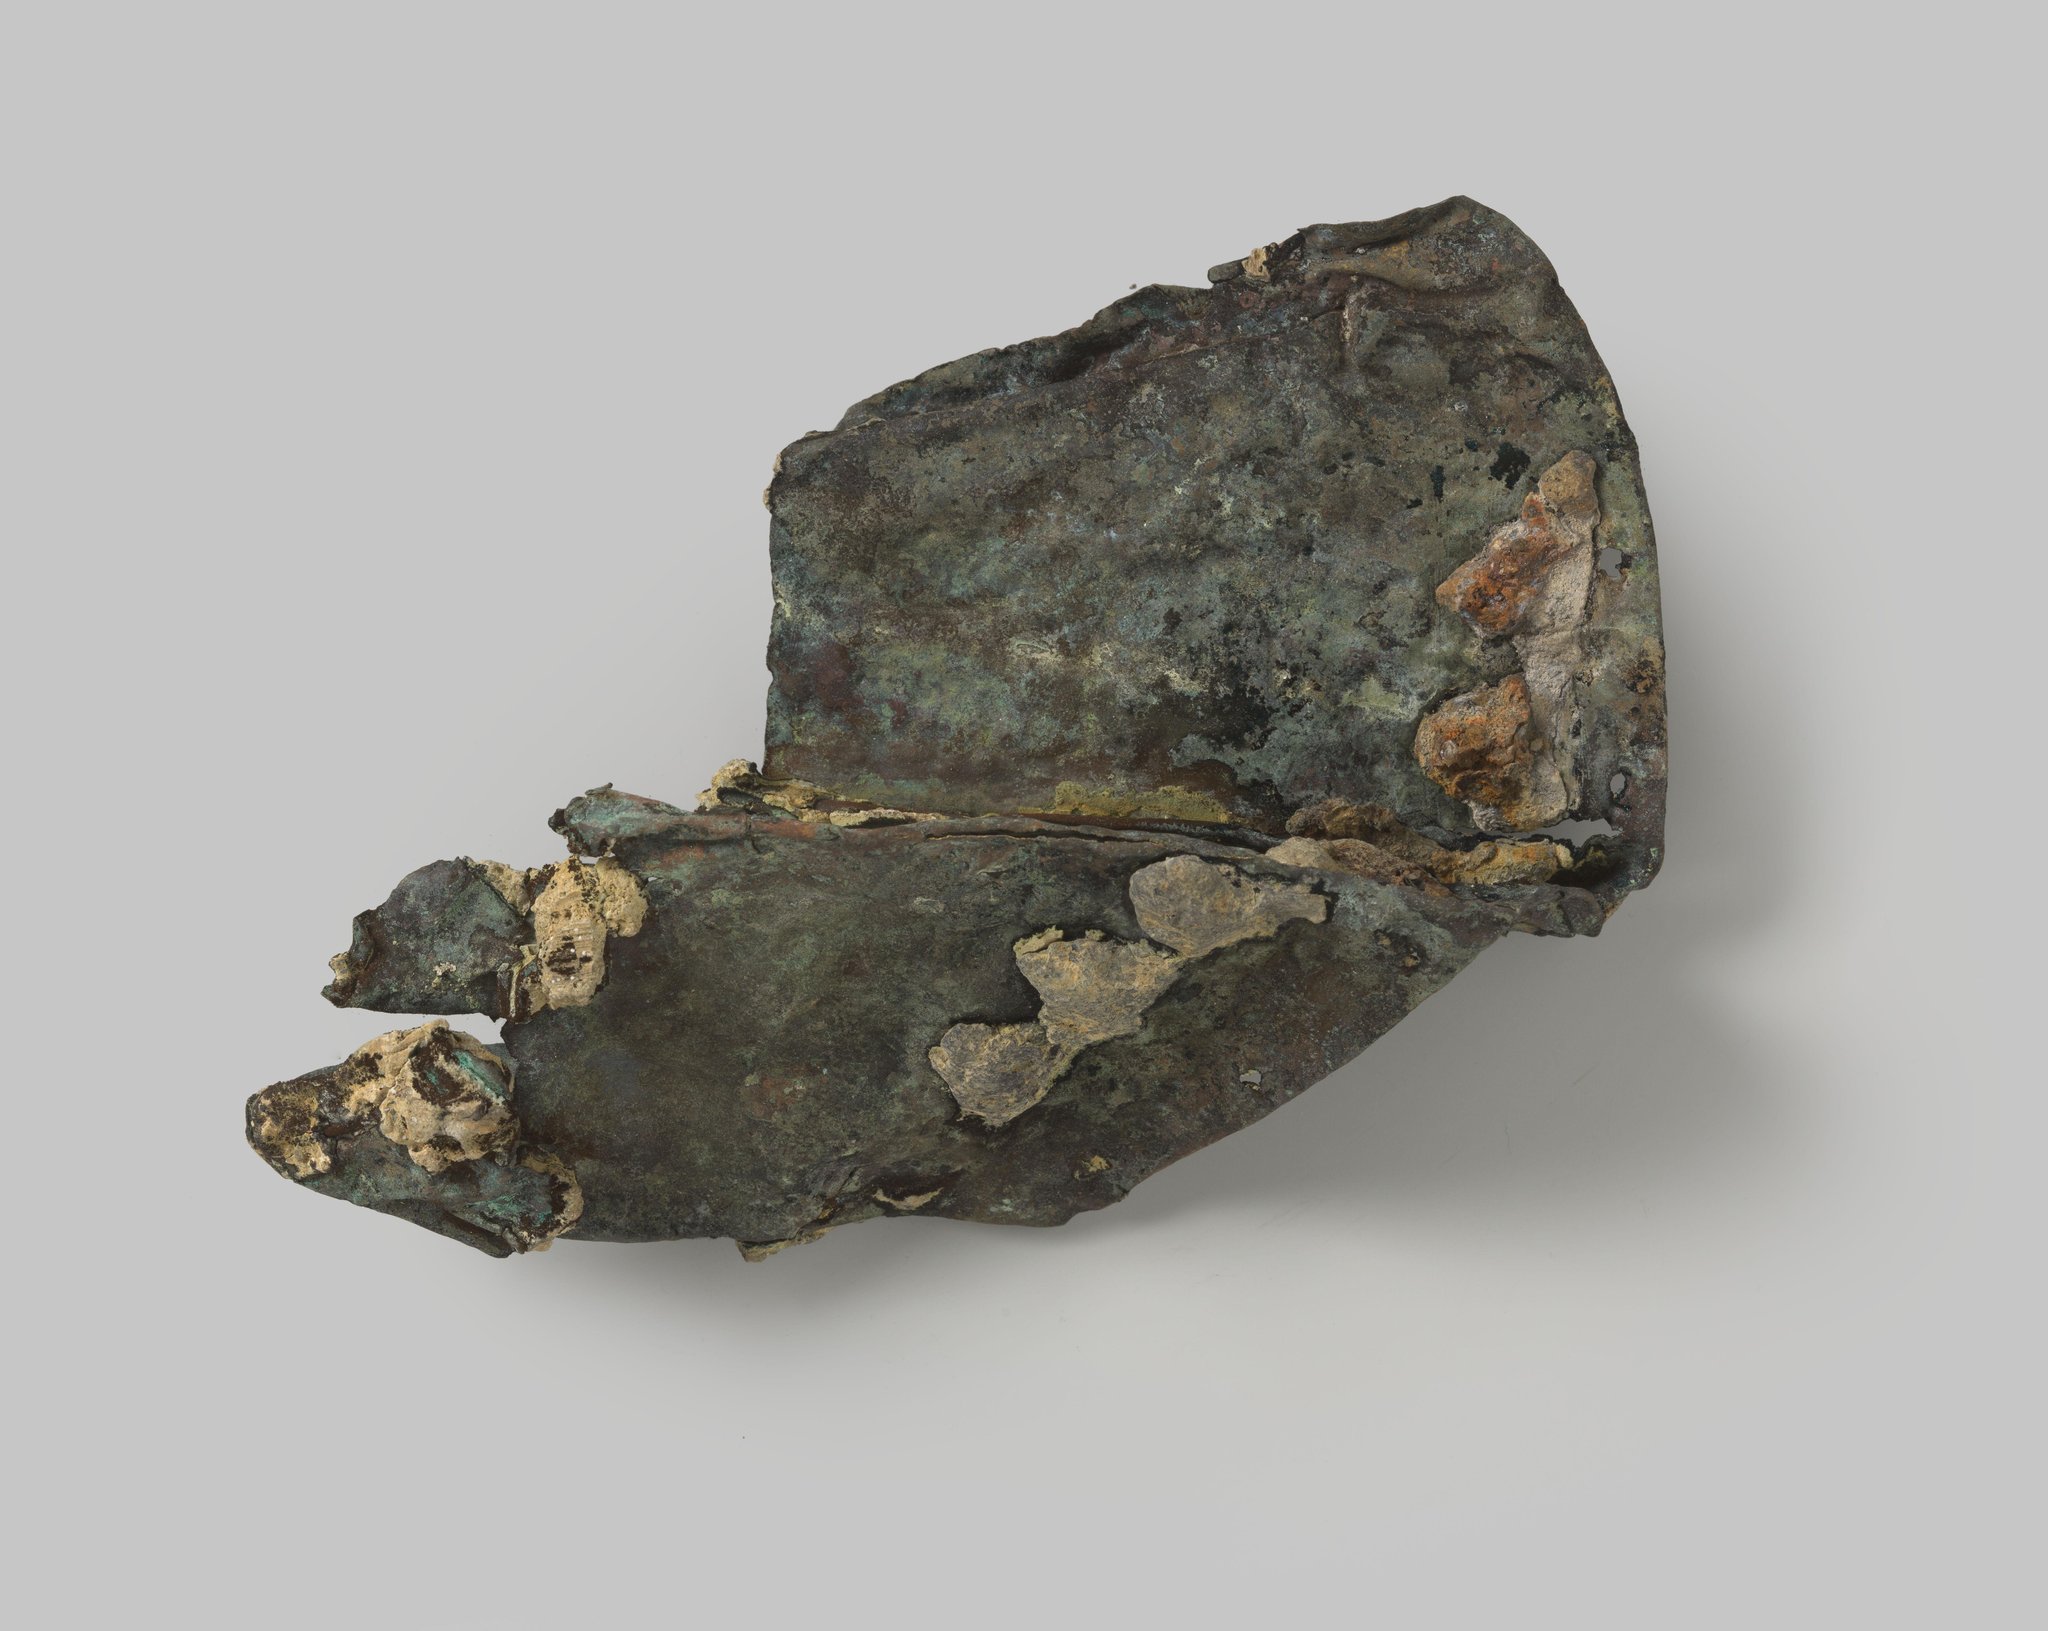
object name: plaatwerk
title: Plaatwerk uit het wrak van de Oostindiëvaarder Hollandia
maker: Anonymous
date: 1700-1743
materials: copper